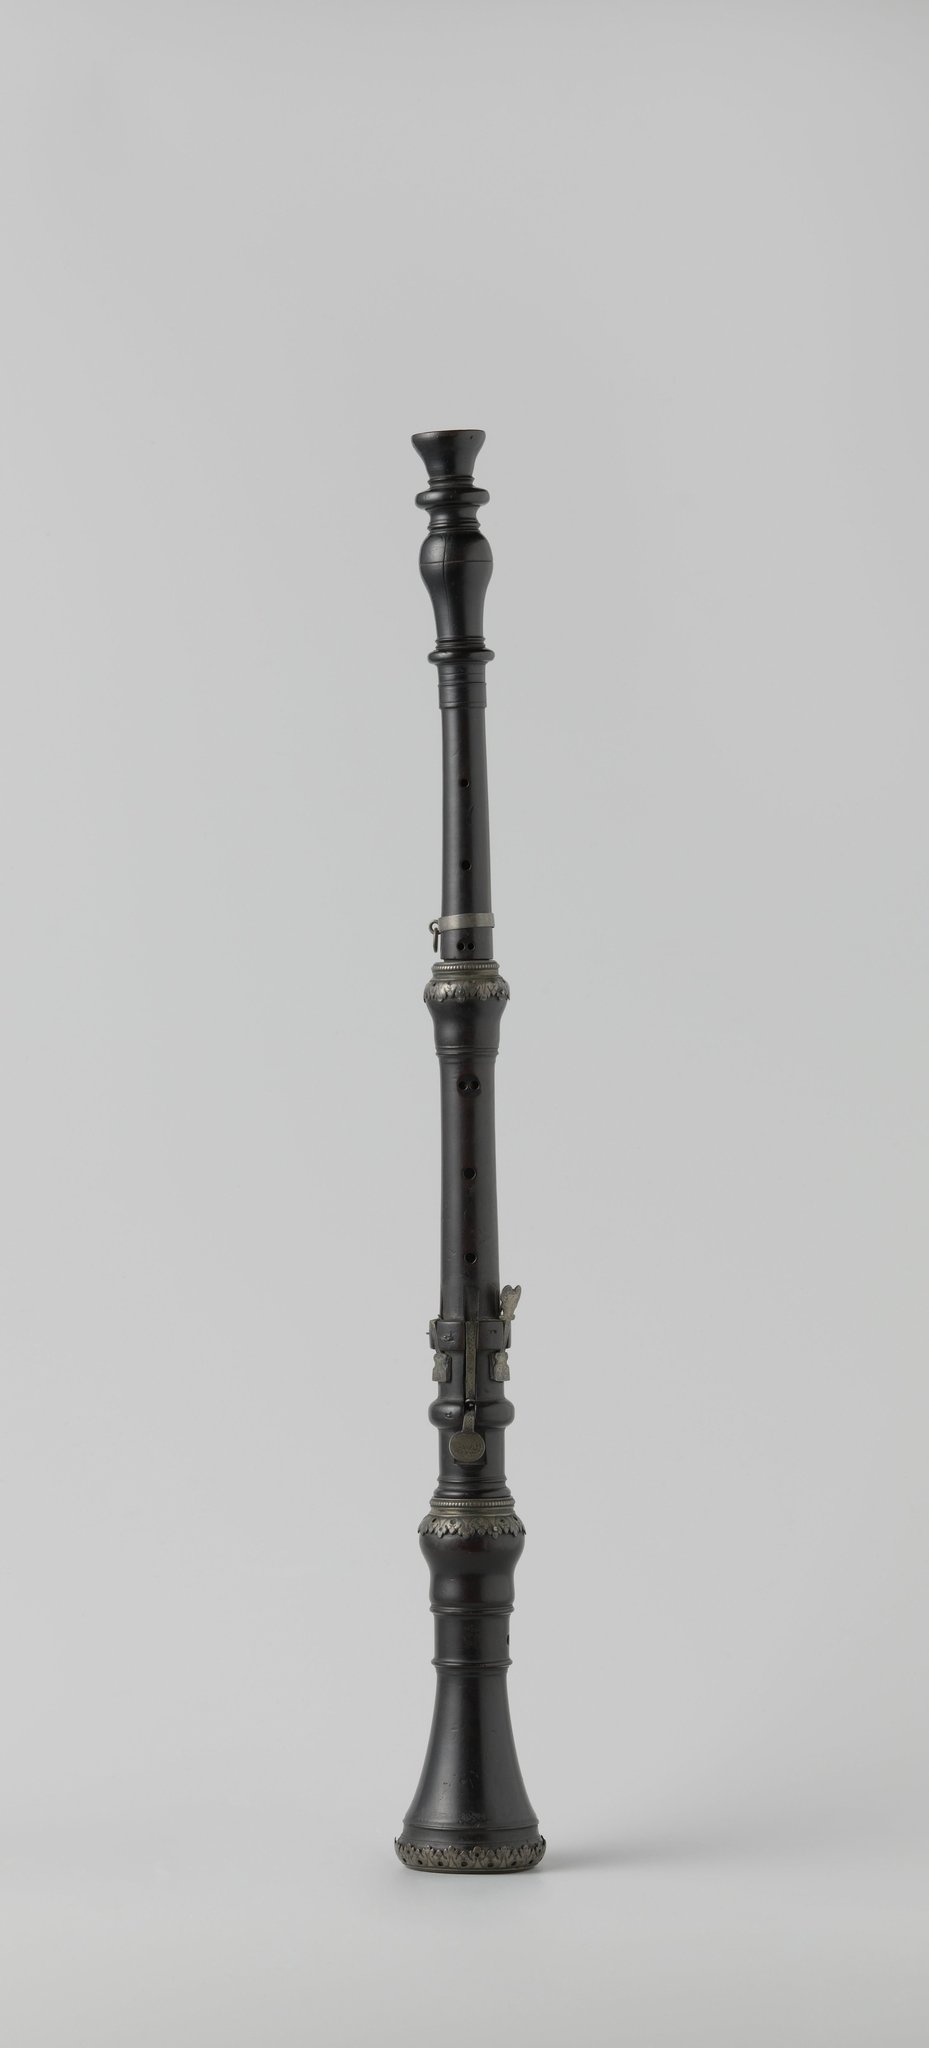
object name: musical instrument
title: Oboe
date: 1720-1750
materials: wood, silver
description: Hobo van buxushout, rijk met zilver gemonteerd, met zilveren beugel, waaraan een ringetje. De zilveren kleppen zijn gegraveerd. Zes gaten. Het instrument bestaat uit drie losse stukken. het mondstuk ontbreekt.